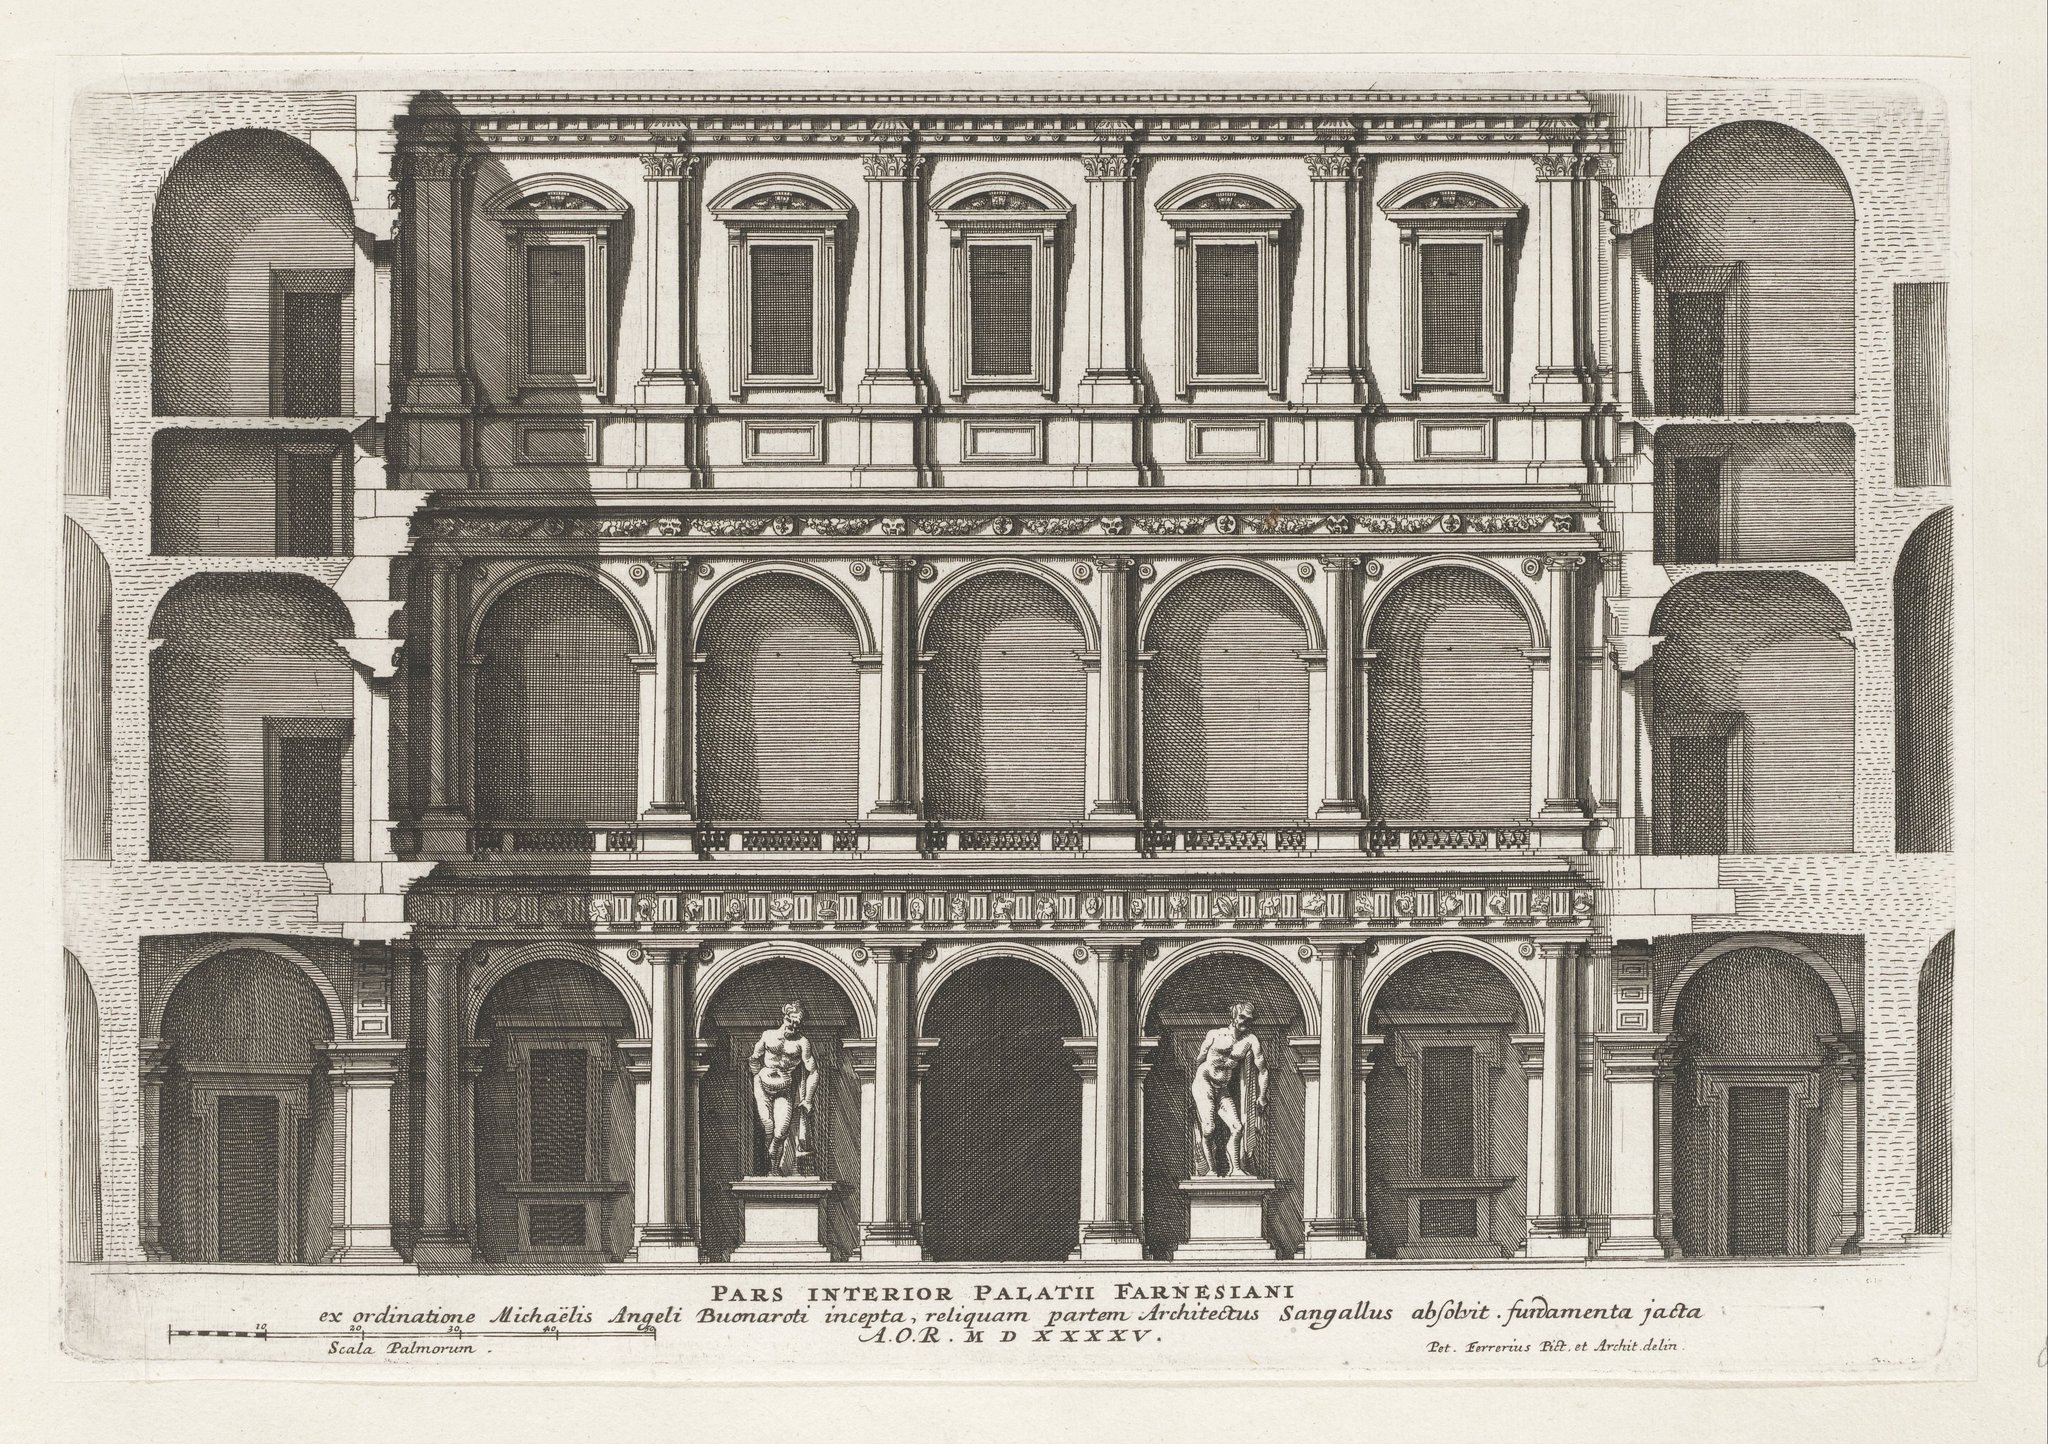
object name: album leaf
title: Pars interior Palatii Farnesiani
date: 1655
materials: paper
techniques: etching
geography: rome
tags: palace, façade of inner court, inner court of palace or 'hôtel'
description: Deze prent maakt deel uit van de reeks getiteld: Palazzi di Roma. Deze reeks bestaat uit twee boeken. Boek één getiteld: Palazzi di Roma dei più celebri architetti..., bestaat uit 44 prenten die worden toegeschreven aan Giovanni Battista Falda (naam staat enkel op prent 27) en uitgegeven door Giovanni Giacomo de'Rossi. Deze 44 prenten zijn bekend in twee staten (met en zonder nummer). Boek twee getiteld: Nuovi disegni dell'architetture... libro secondo, bevat 66 prenten door Giovanni Battista Falda en Simone Felice. Deze 66 prenten zijn bekend in twee staten (met en zonder nummer).